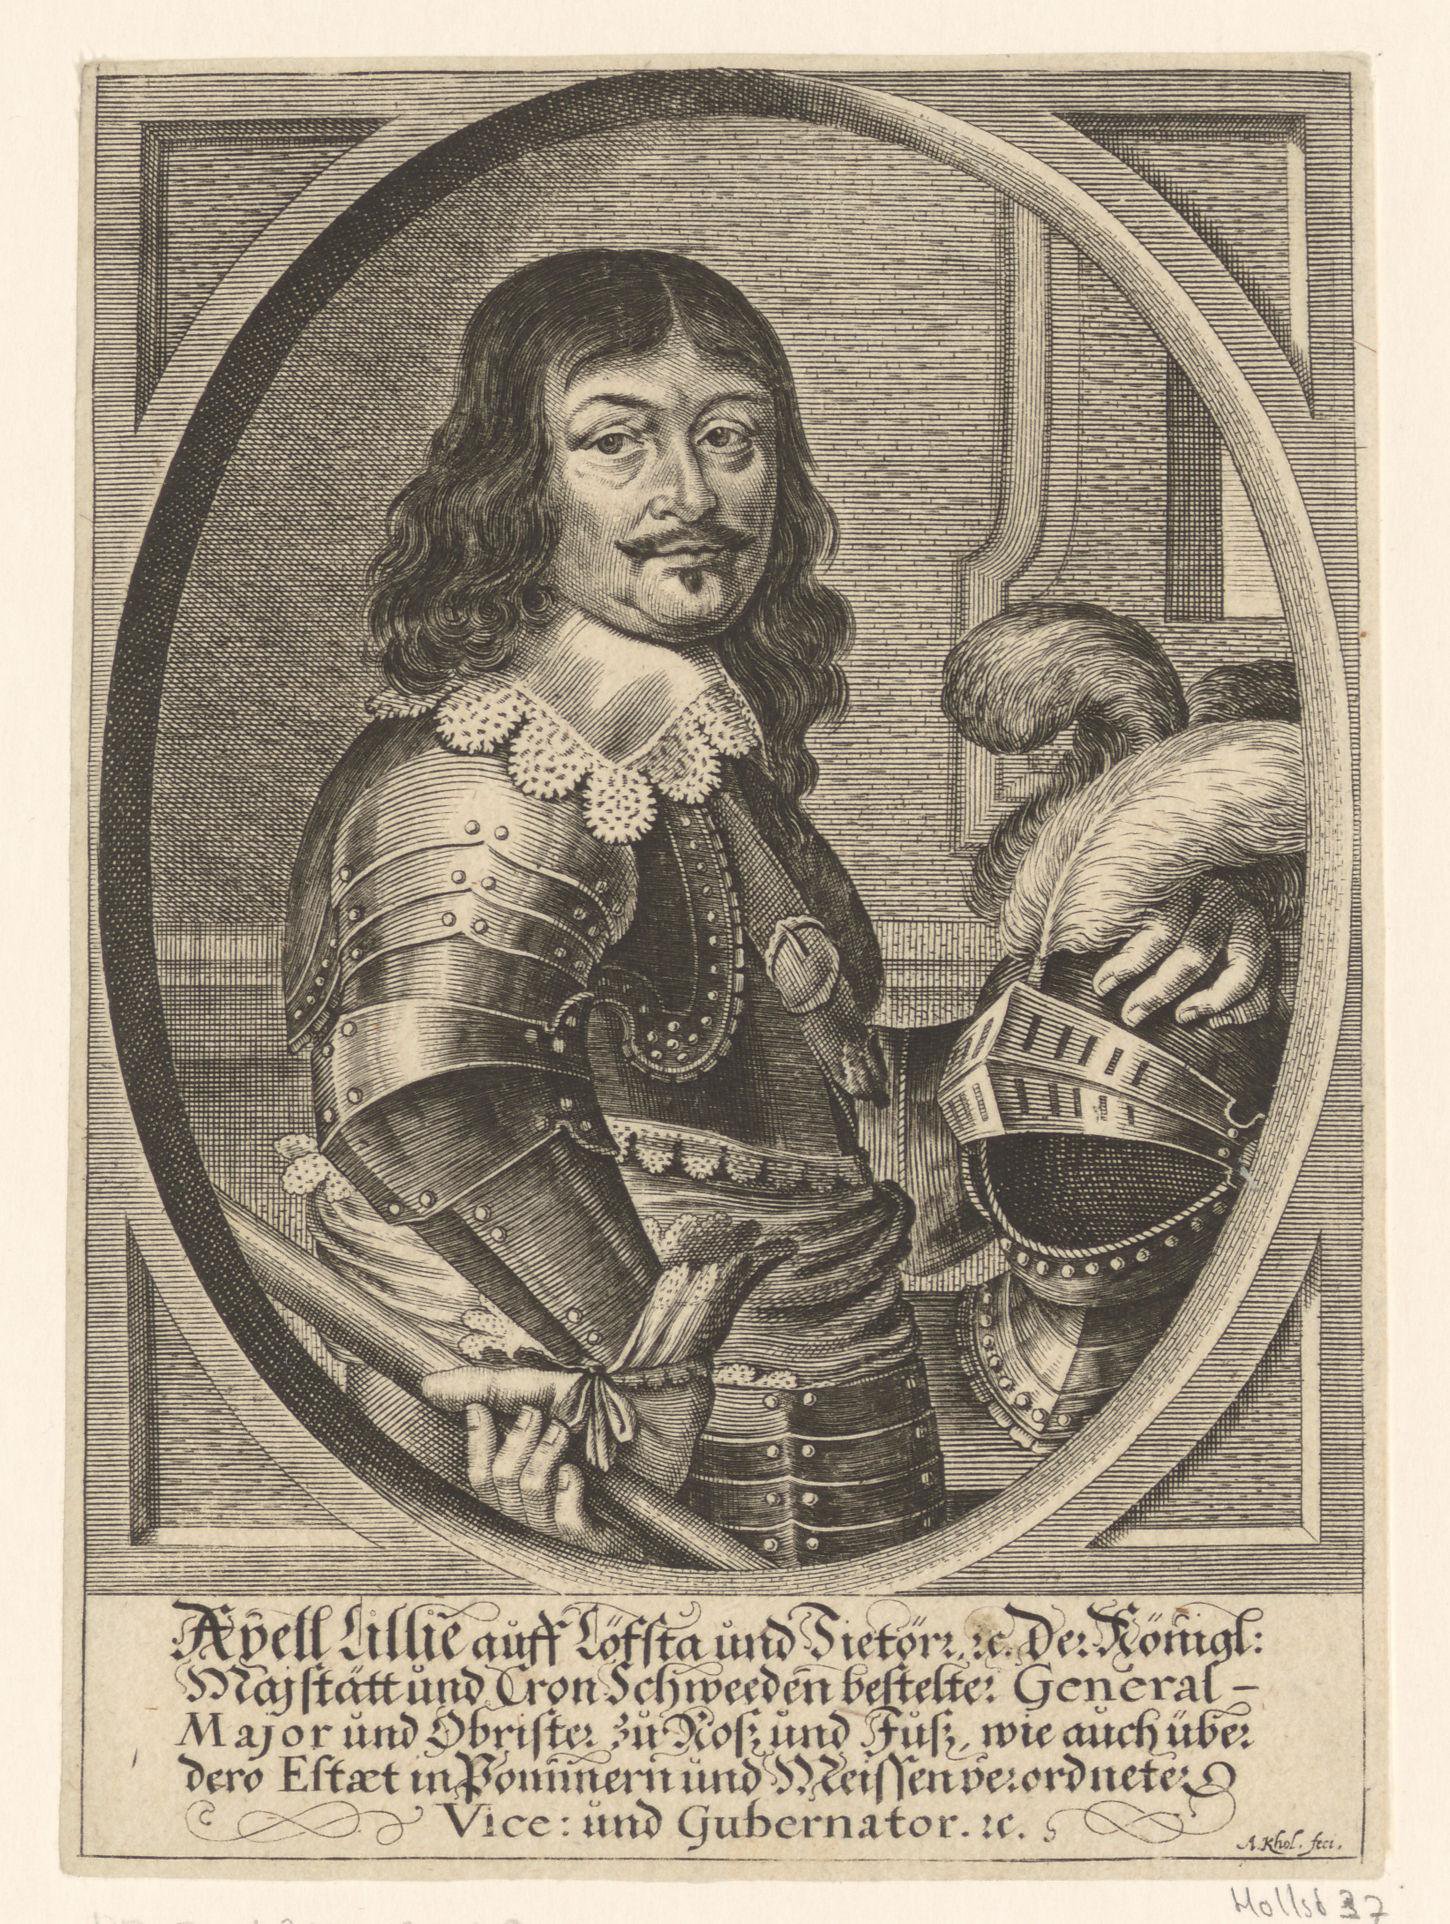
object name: print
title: Portret van Axel Lillie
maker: andreas kohl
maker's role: print maker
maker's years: 1624-1657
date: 1634-1657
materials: paper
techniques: engraving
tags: commander-in-chief, general, marshal, armour, historical persons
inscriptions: collector's mark: Lugt 2228